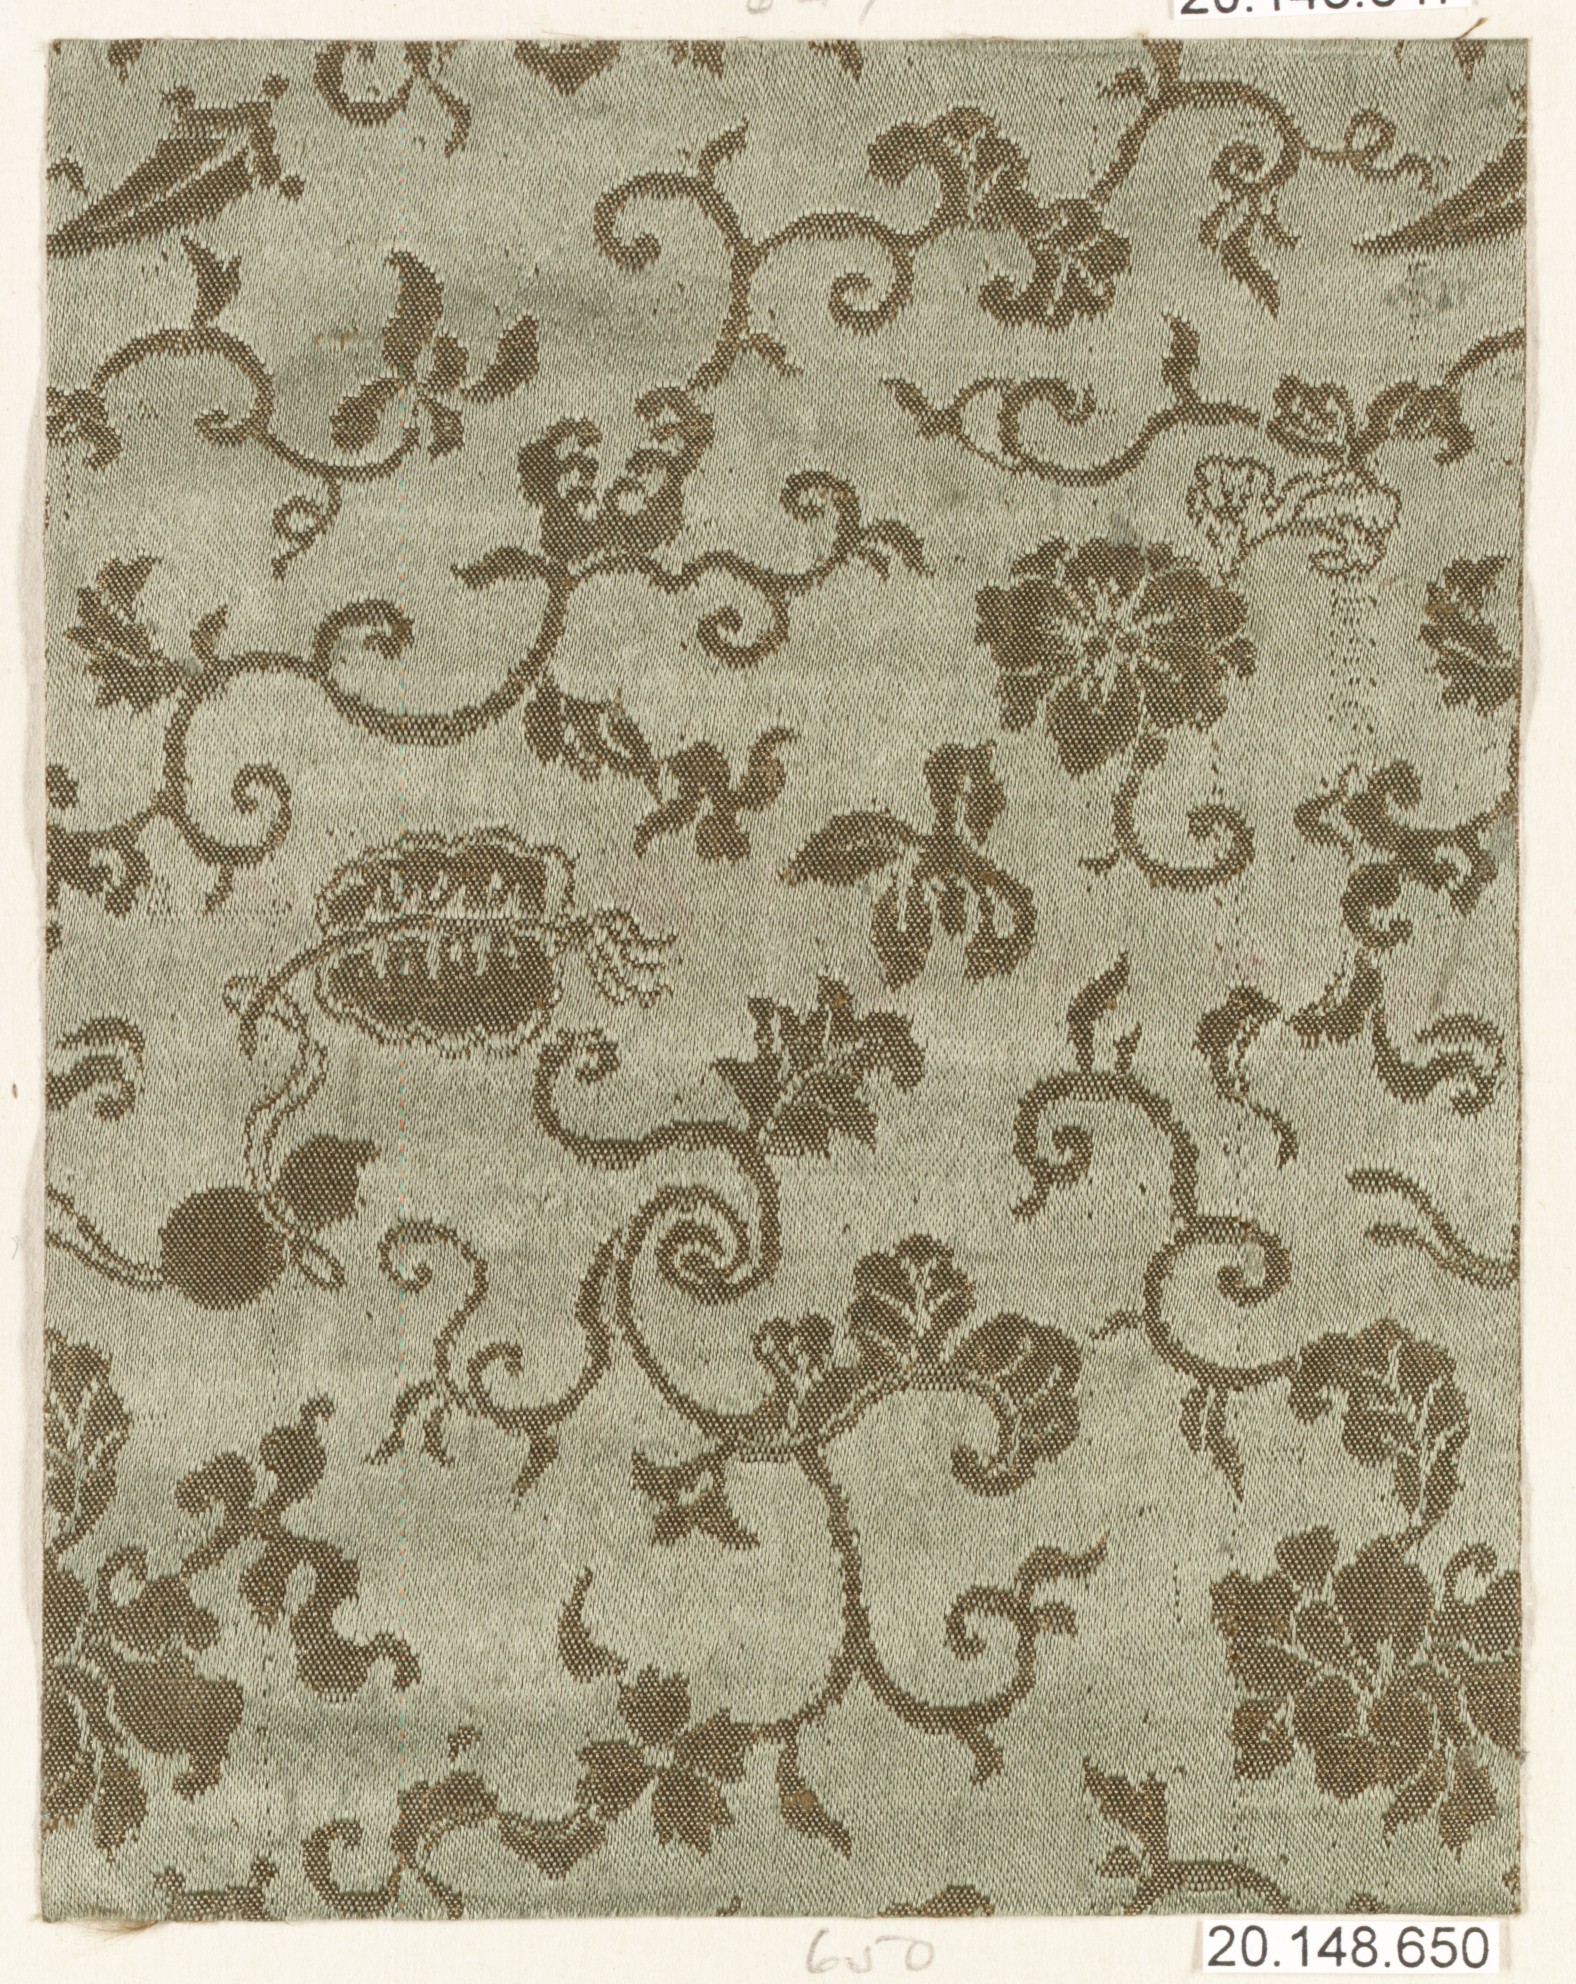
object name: piece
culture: japanese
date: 1701-1800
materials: silk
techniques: compound weave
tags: flowers